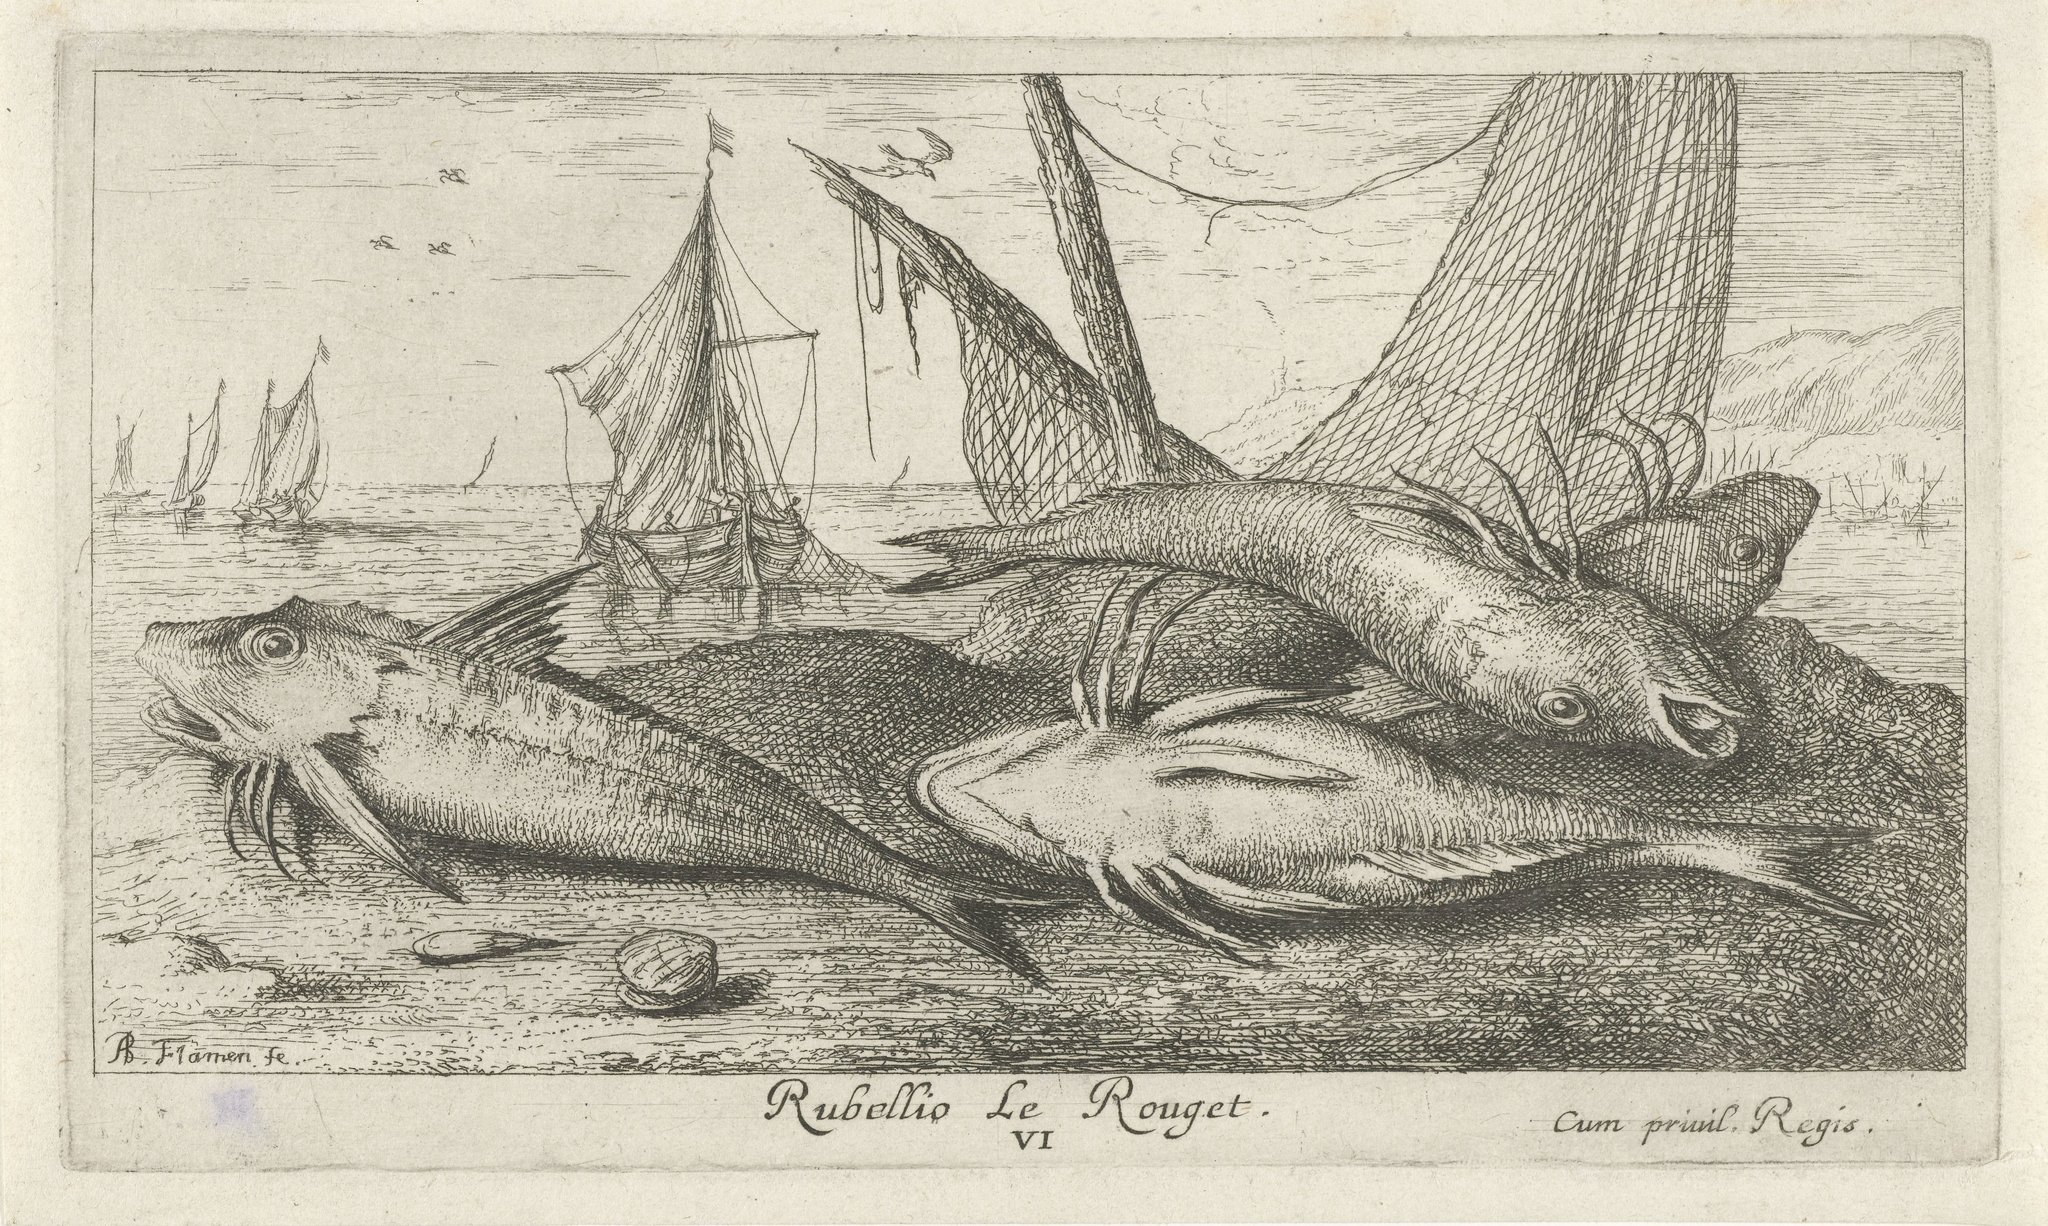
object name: print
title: Poissons de mer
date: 1664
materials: paper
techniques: etching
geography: paris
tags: bony fishes: mullet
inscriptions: collector's mark: Lugt 1490, collector's mark: Lugt 2228